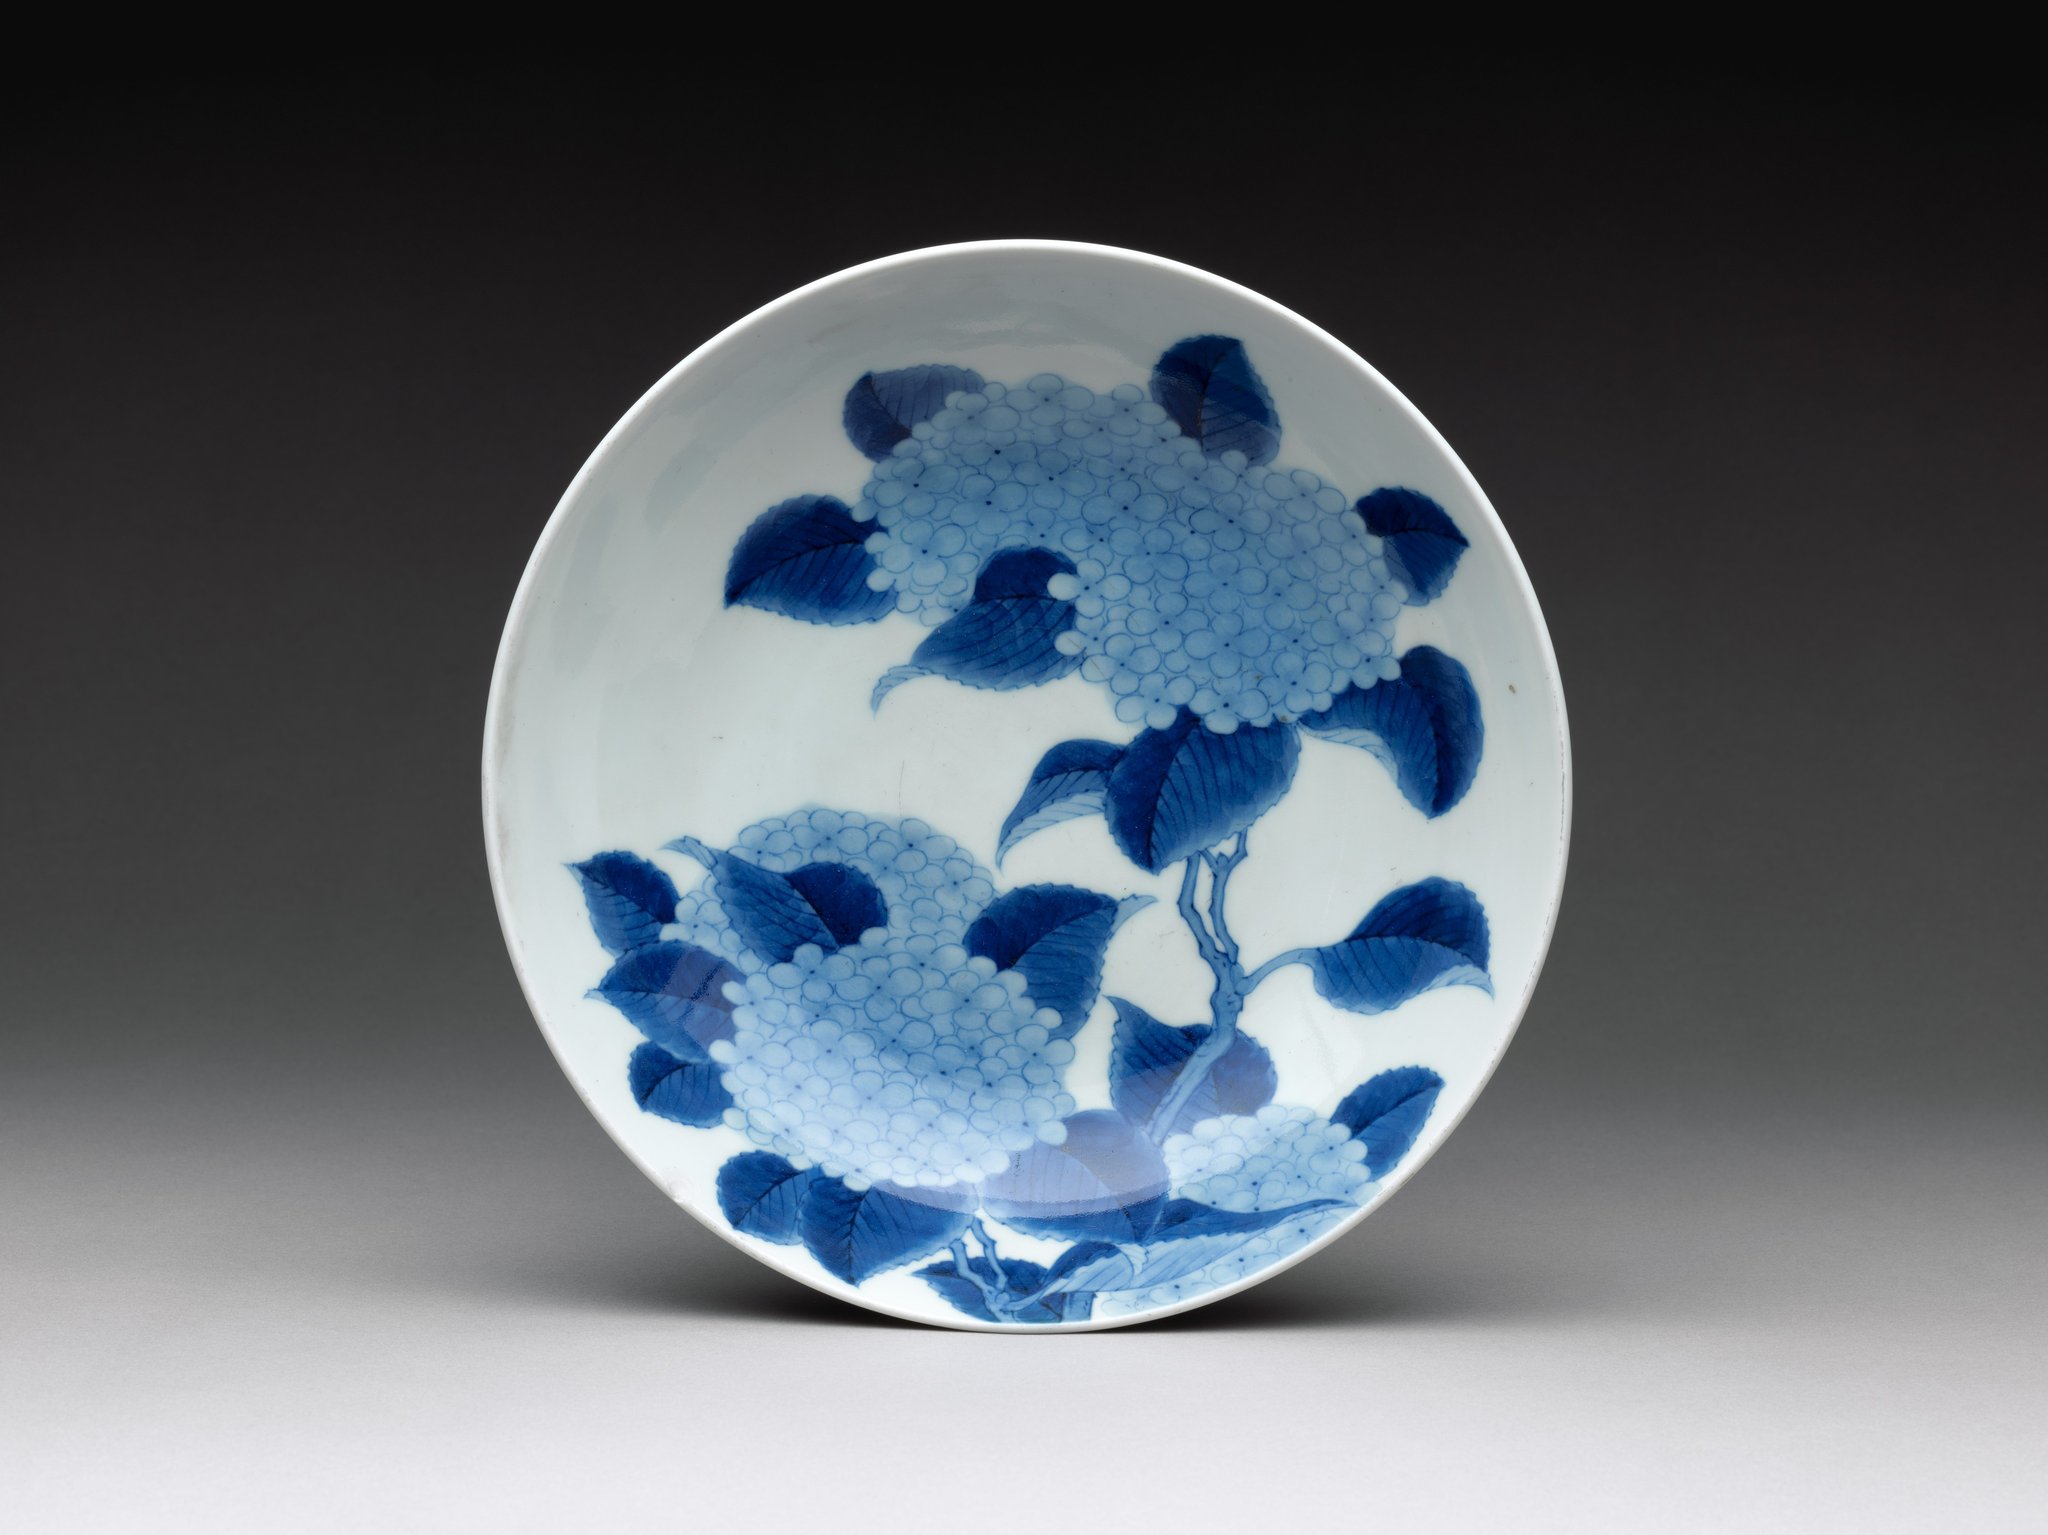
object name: dish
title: Dish with Hydrangeas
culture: japanese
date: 1800-1860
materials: porcelain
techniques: underglaze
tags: flowers,leaves